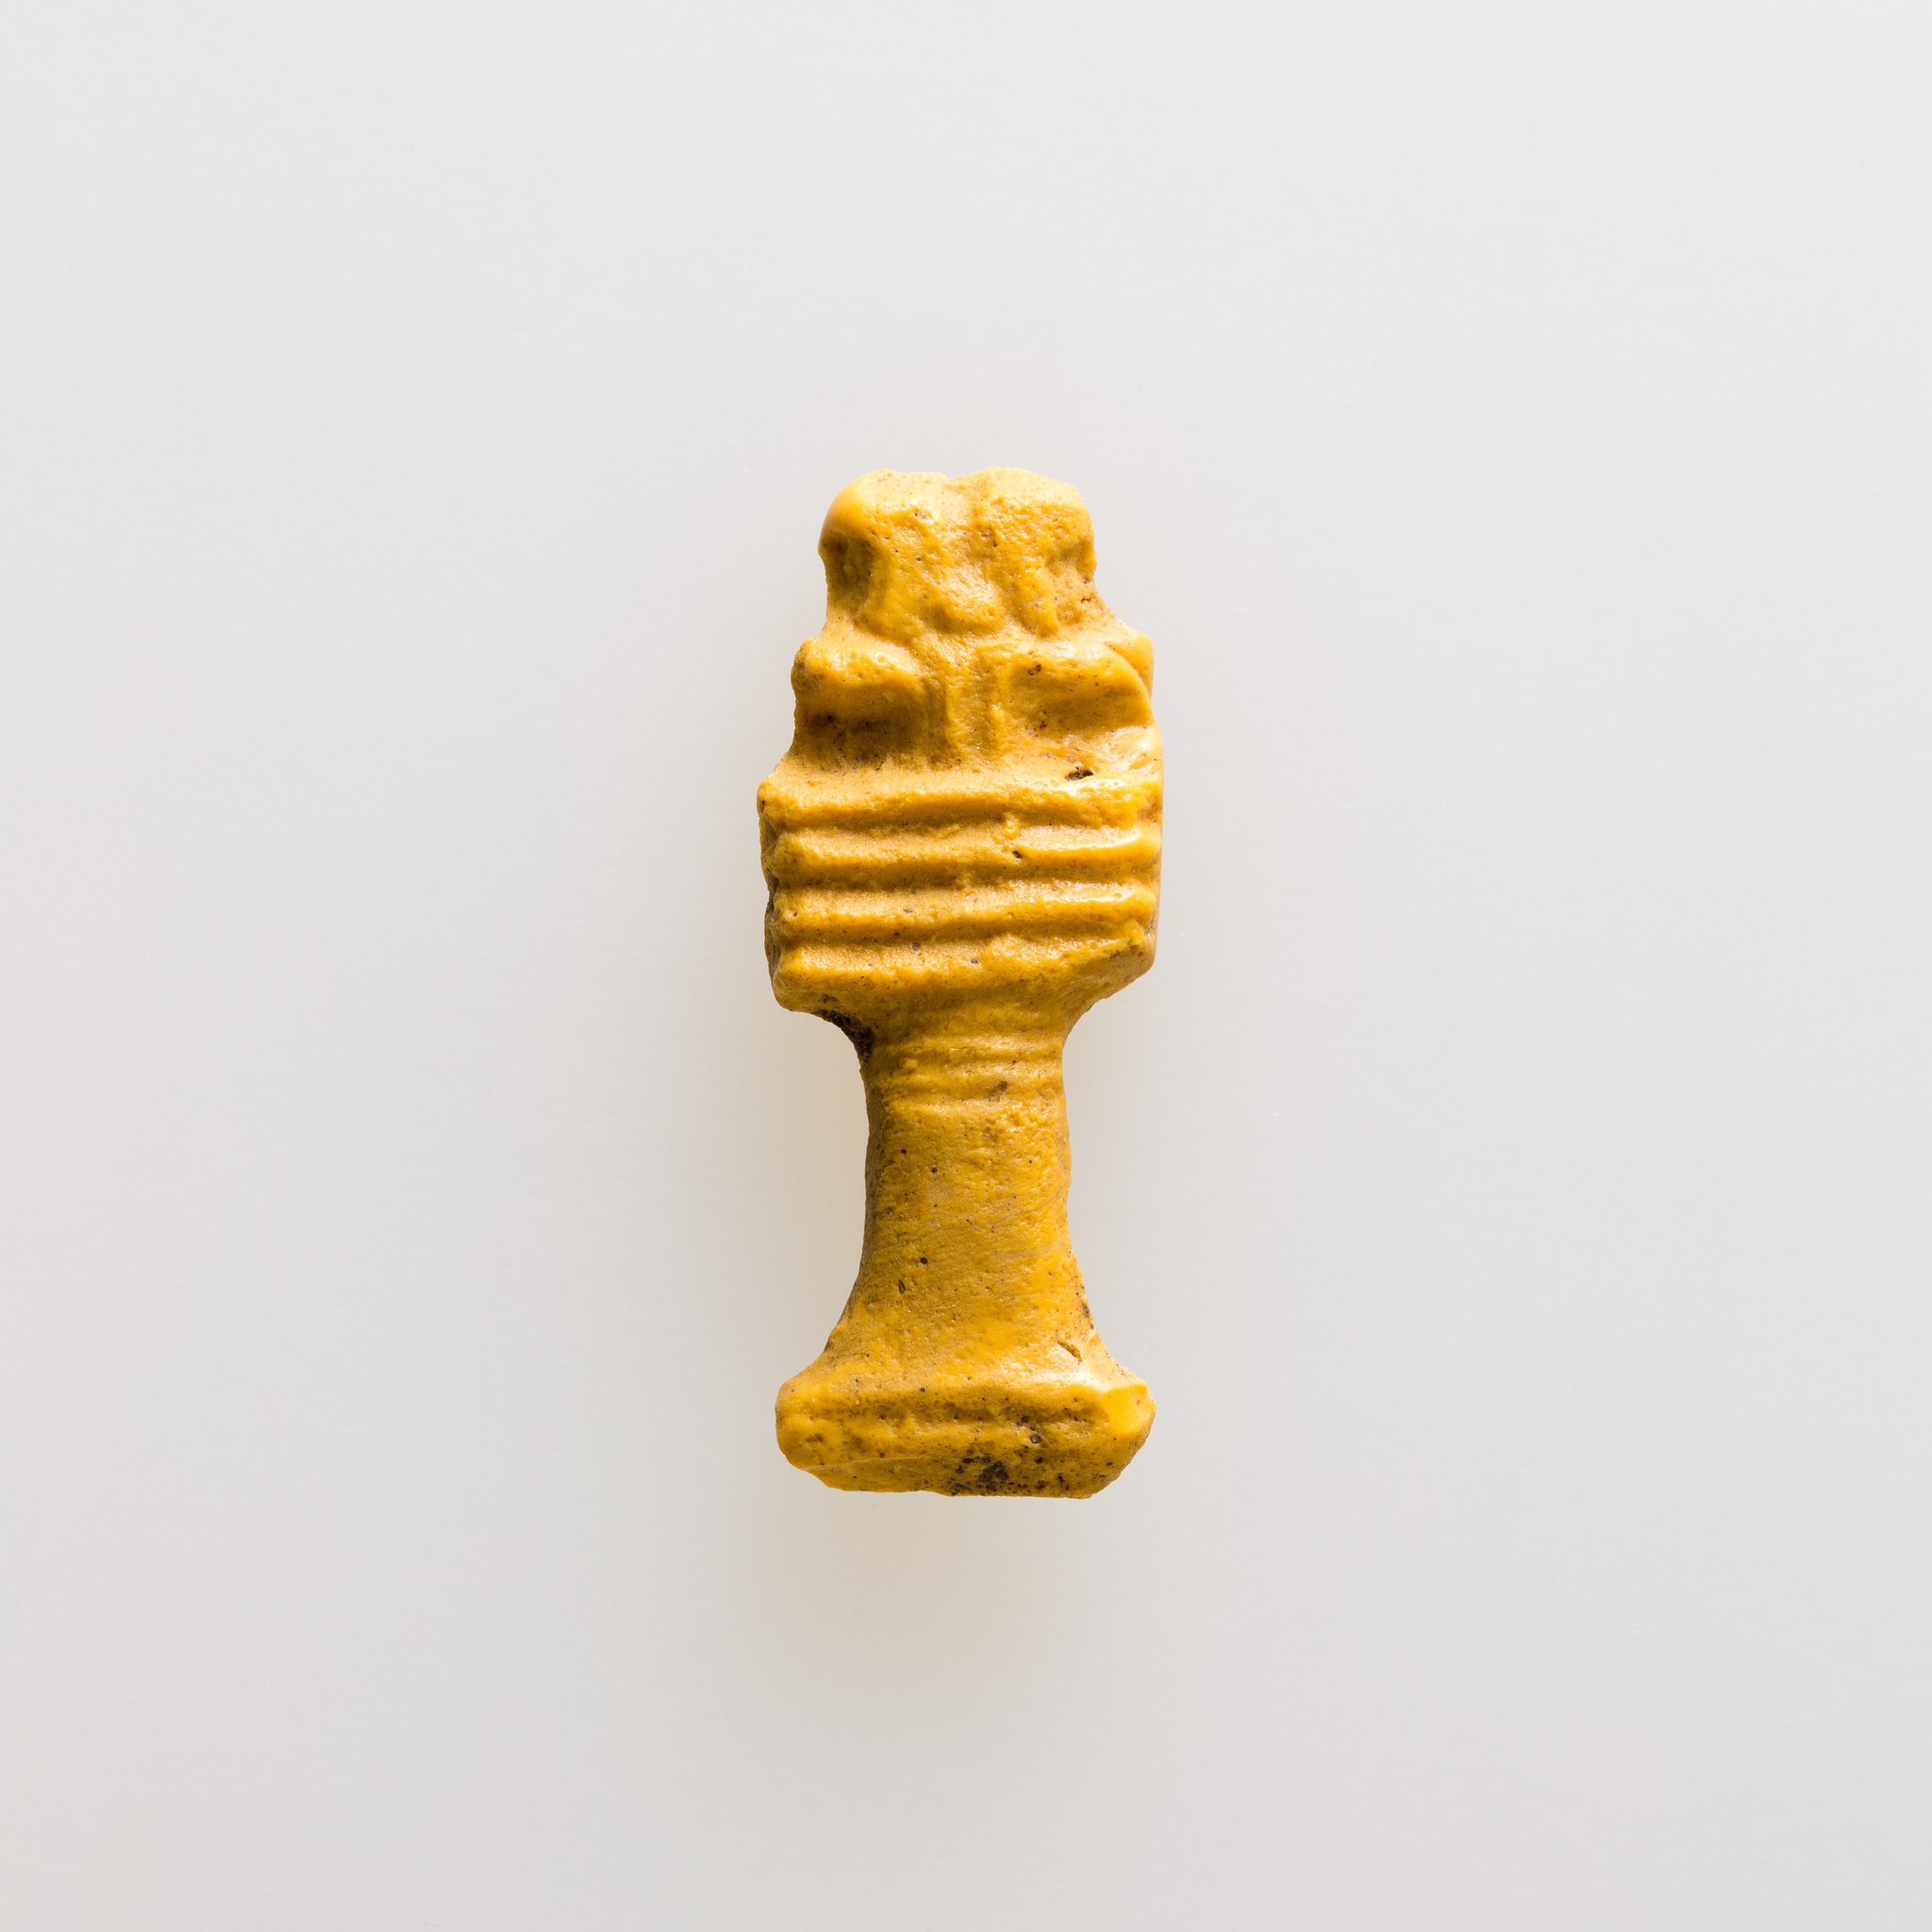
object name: amulet, djed pillar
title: Djed pillar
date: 525-30 BCE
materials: glass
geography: egypt